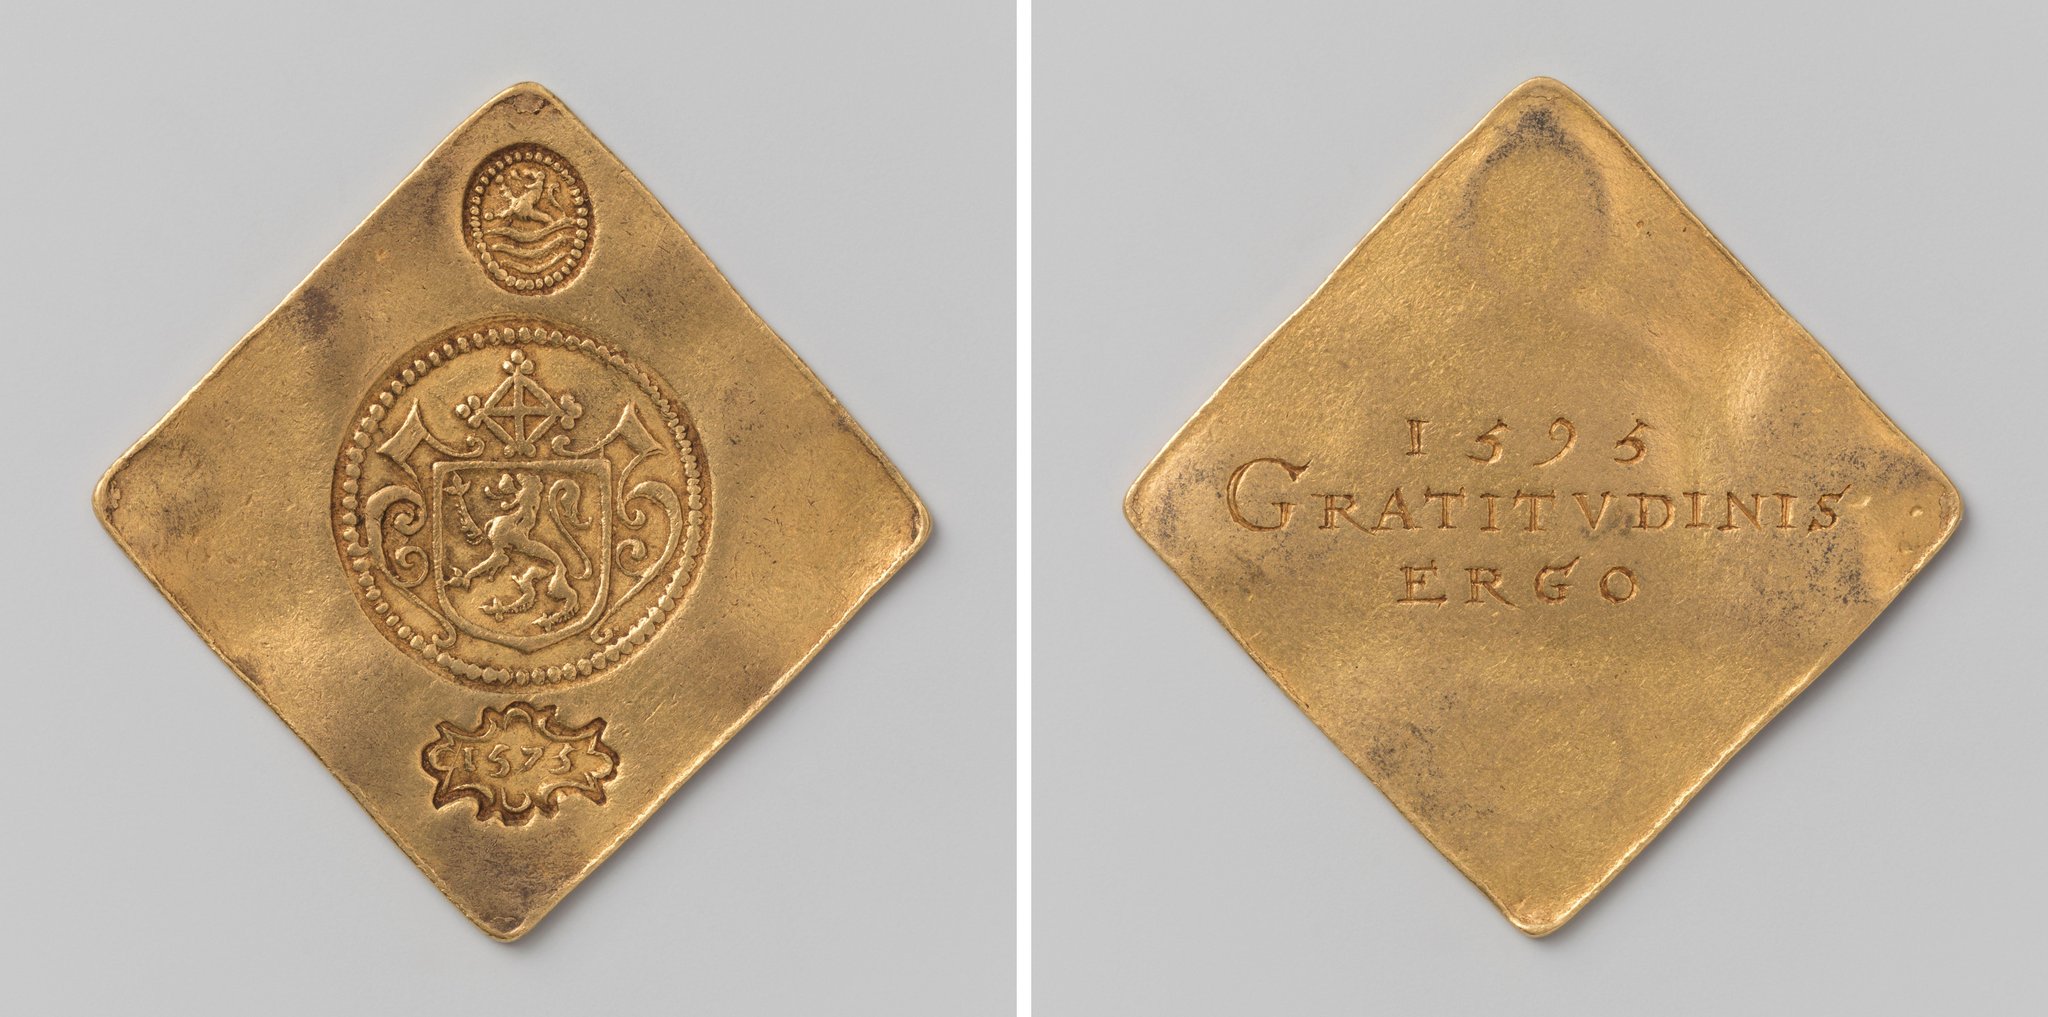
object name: coin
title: Penning in de vorm van een noodmunt uit Zierikzee, latere afslag van een noodmunt geslagen tijdens het beleg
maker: Anonymous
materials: gold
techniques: engraving, striking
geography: netherlands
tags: zierikzee, tachtigjarige oorlog, beleg van zierikzee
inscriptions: inscription: ‘1595 / GRATITVDINIS / ERGO’